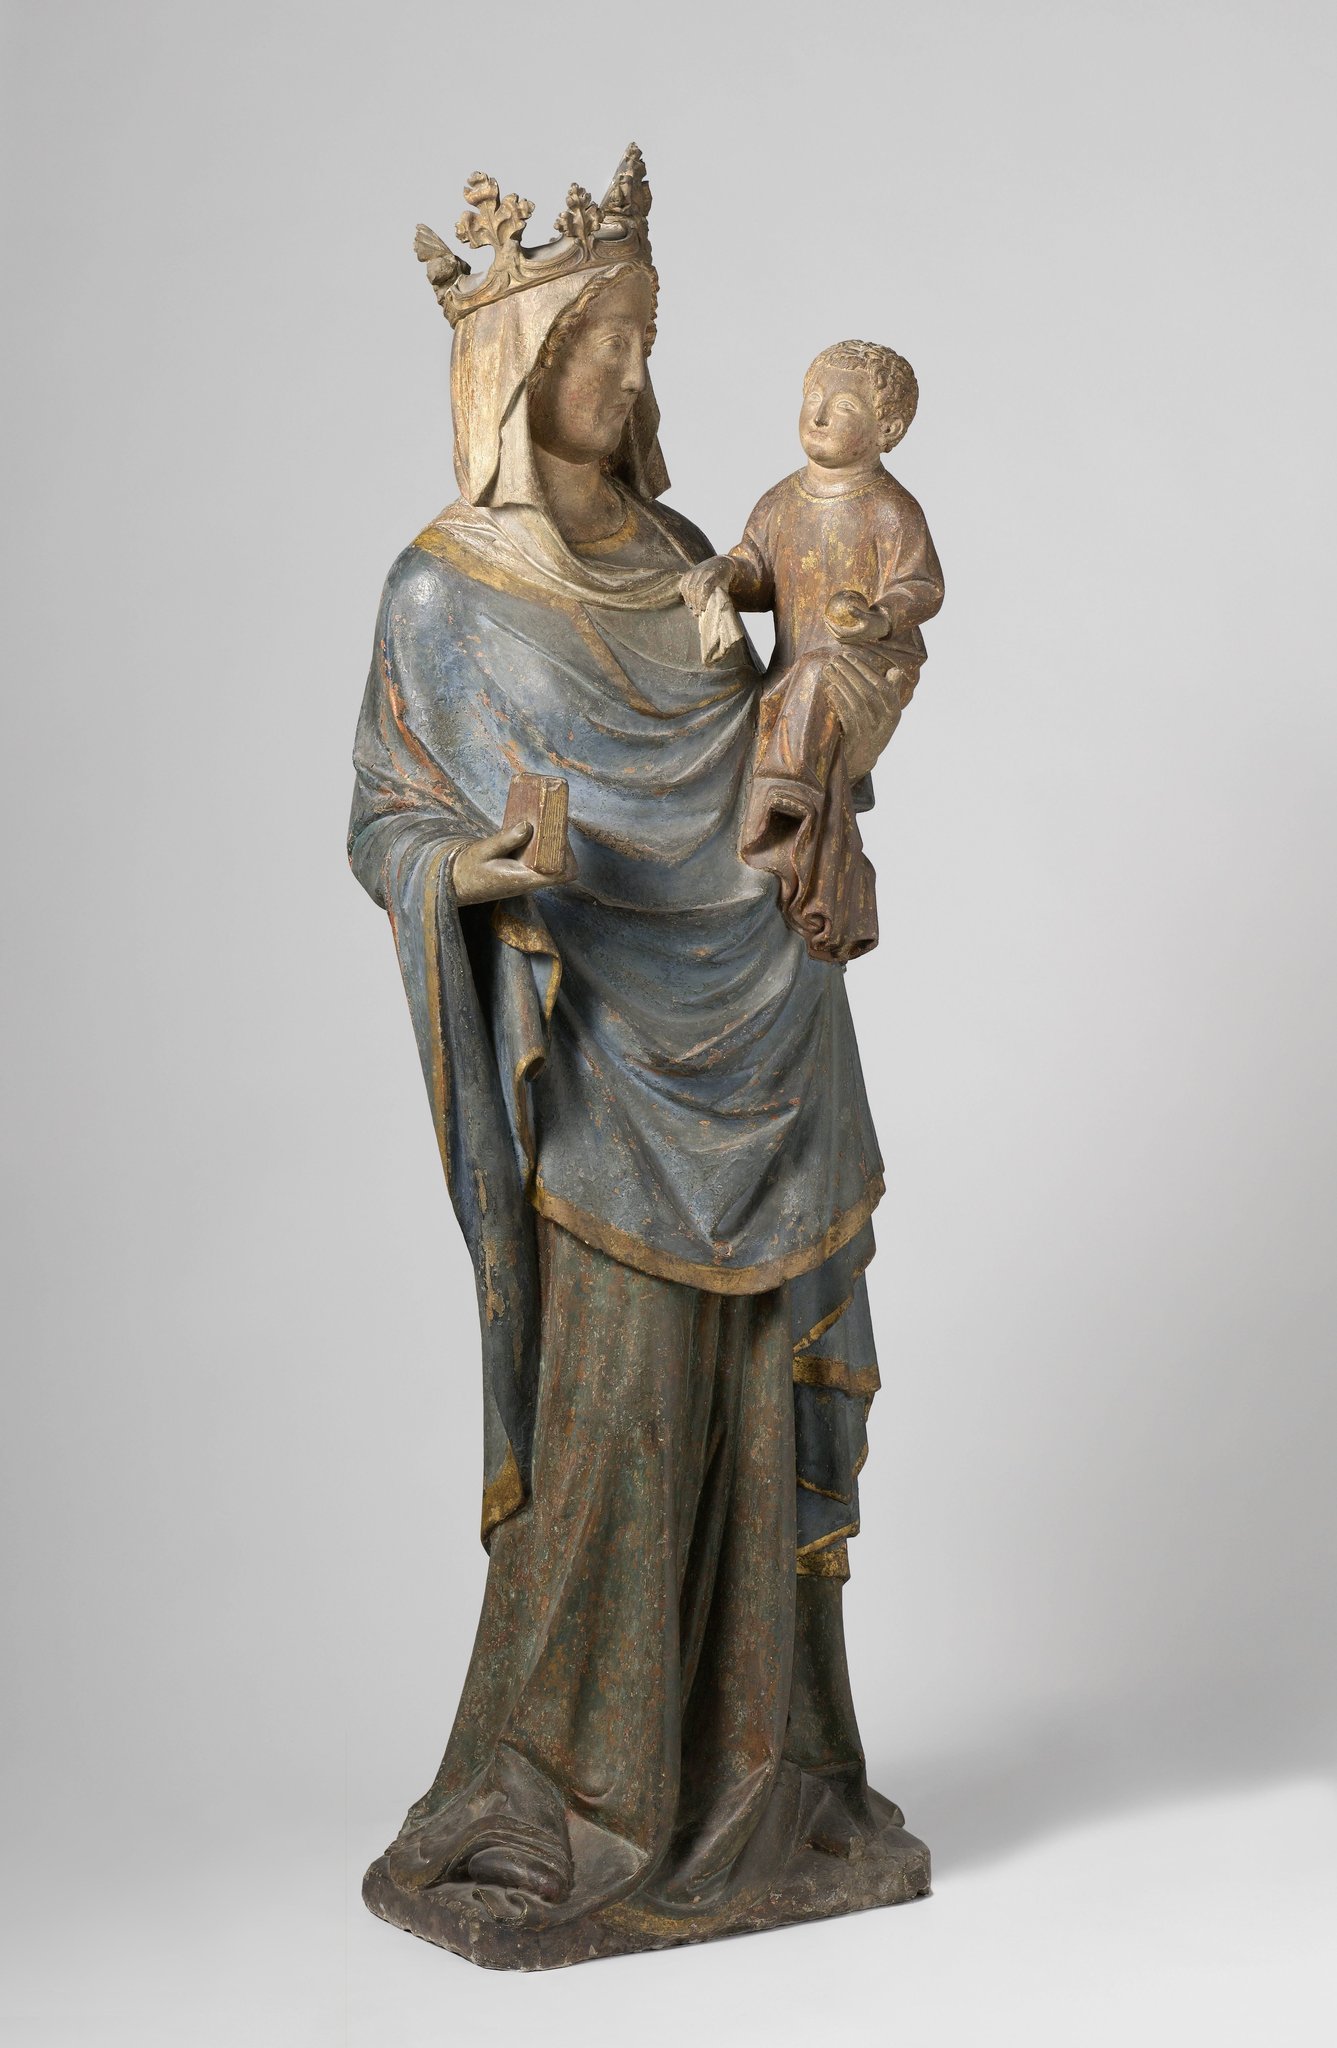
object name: figure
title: Virgin and Child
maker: Anonymous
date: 1325-1349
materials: stone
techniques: polychromy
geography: ile-de-france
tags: mary standing (or half-length), the christ-child sitting on her arm (christ-child to mary's left)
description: From the 13th century onwards, life-size statues of the Virgin and Child were found throughout Europe. In form, they reflected monumental statues in large French cathedrals in cities such as Paris, Chartres, Amiens and Reims.